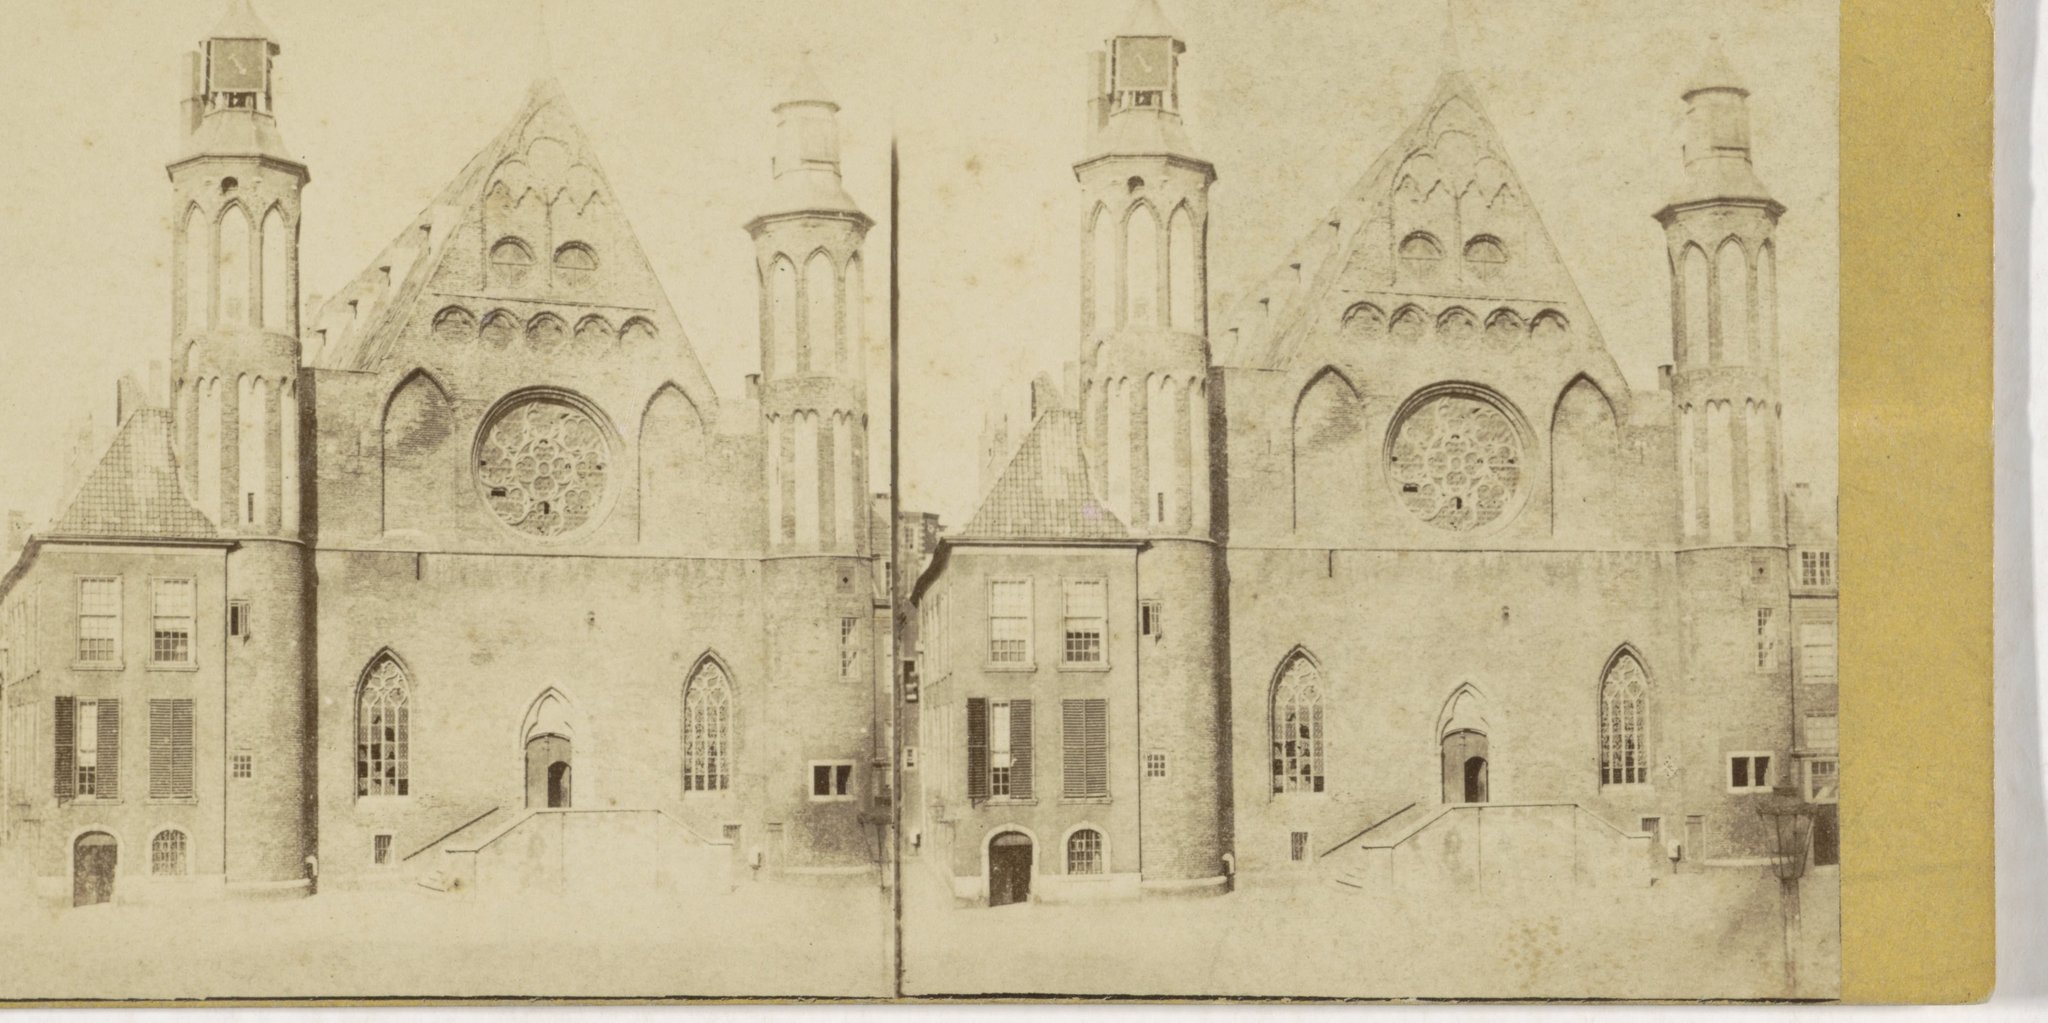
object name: stereograph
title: Loterij Zaal Binnenhof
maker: Anonymous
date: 1852-1863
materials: cardboard, paper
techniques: albumen print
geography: the hague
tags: façade (of house or building)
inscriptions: inscription: ‘fo-50’